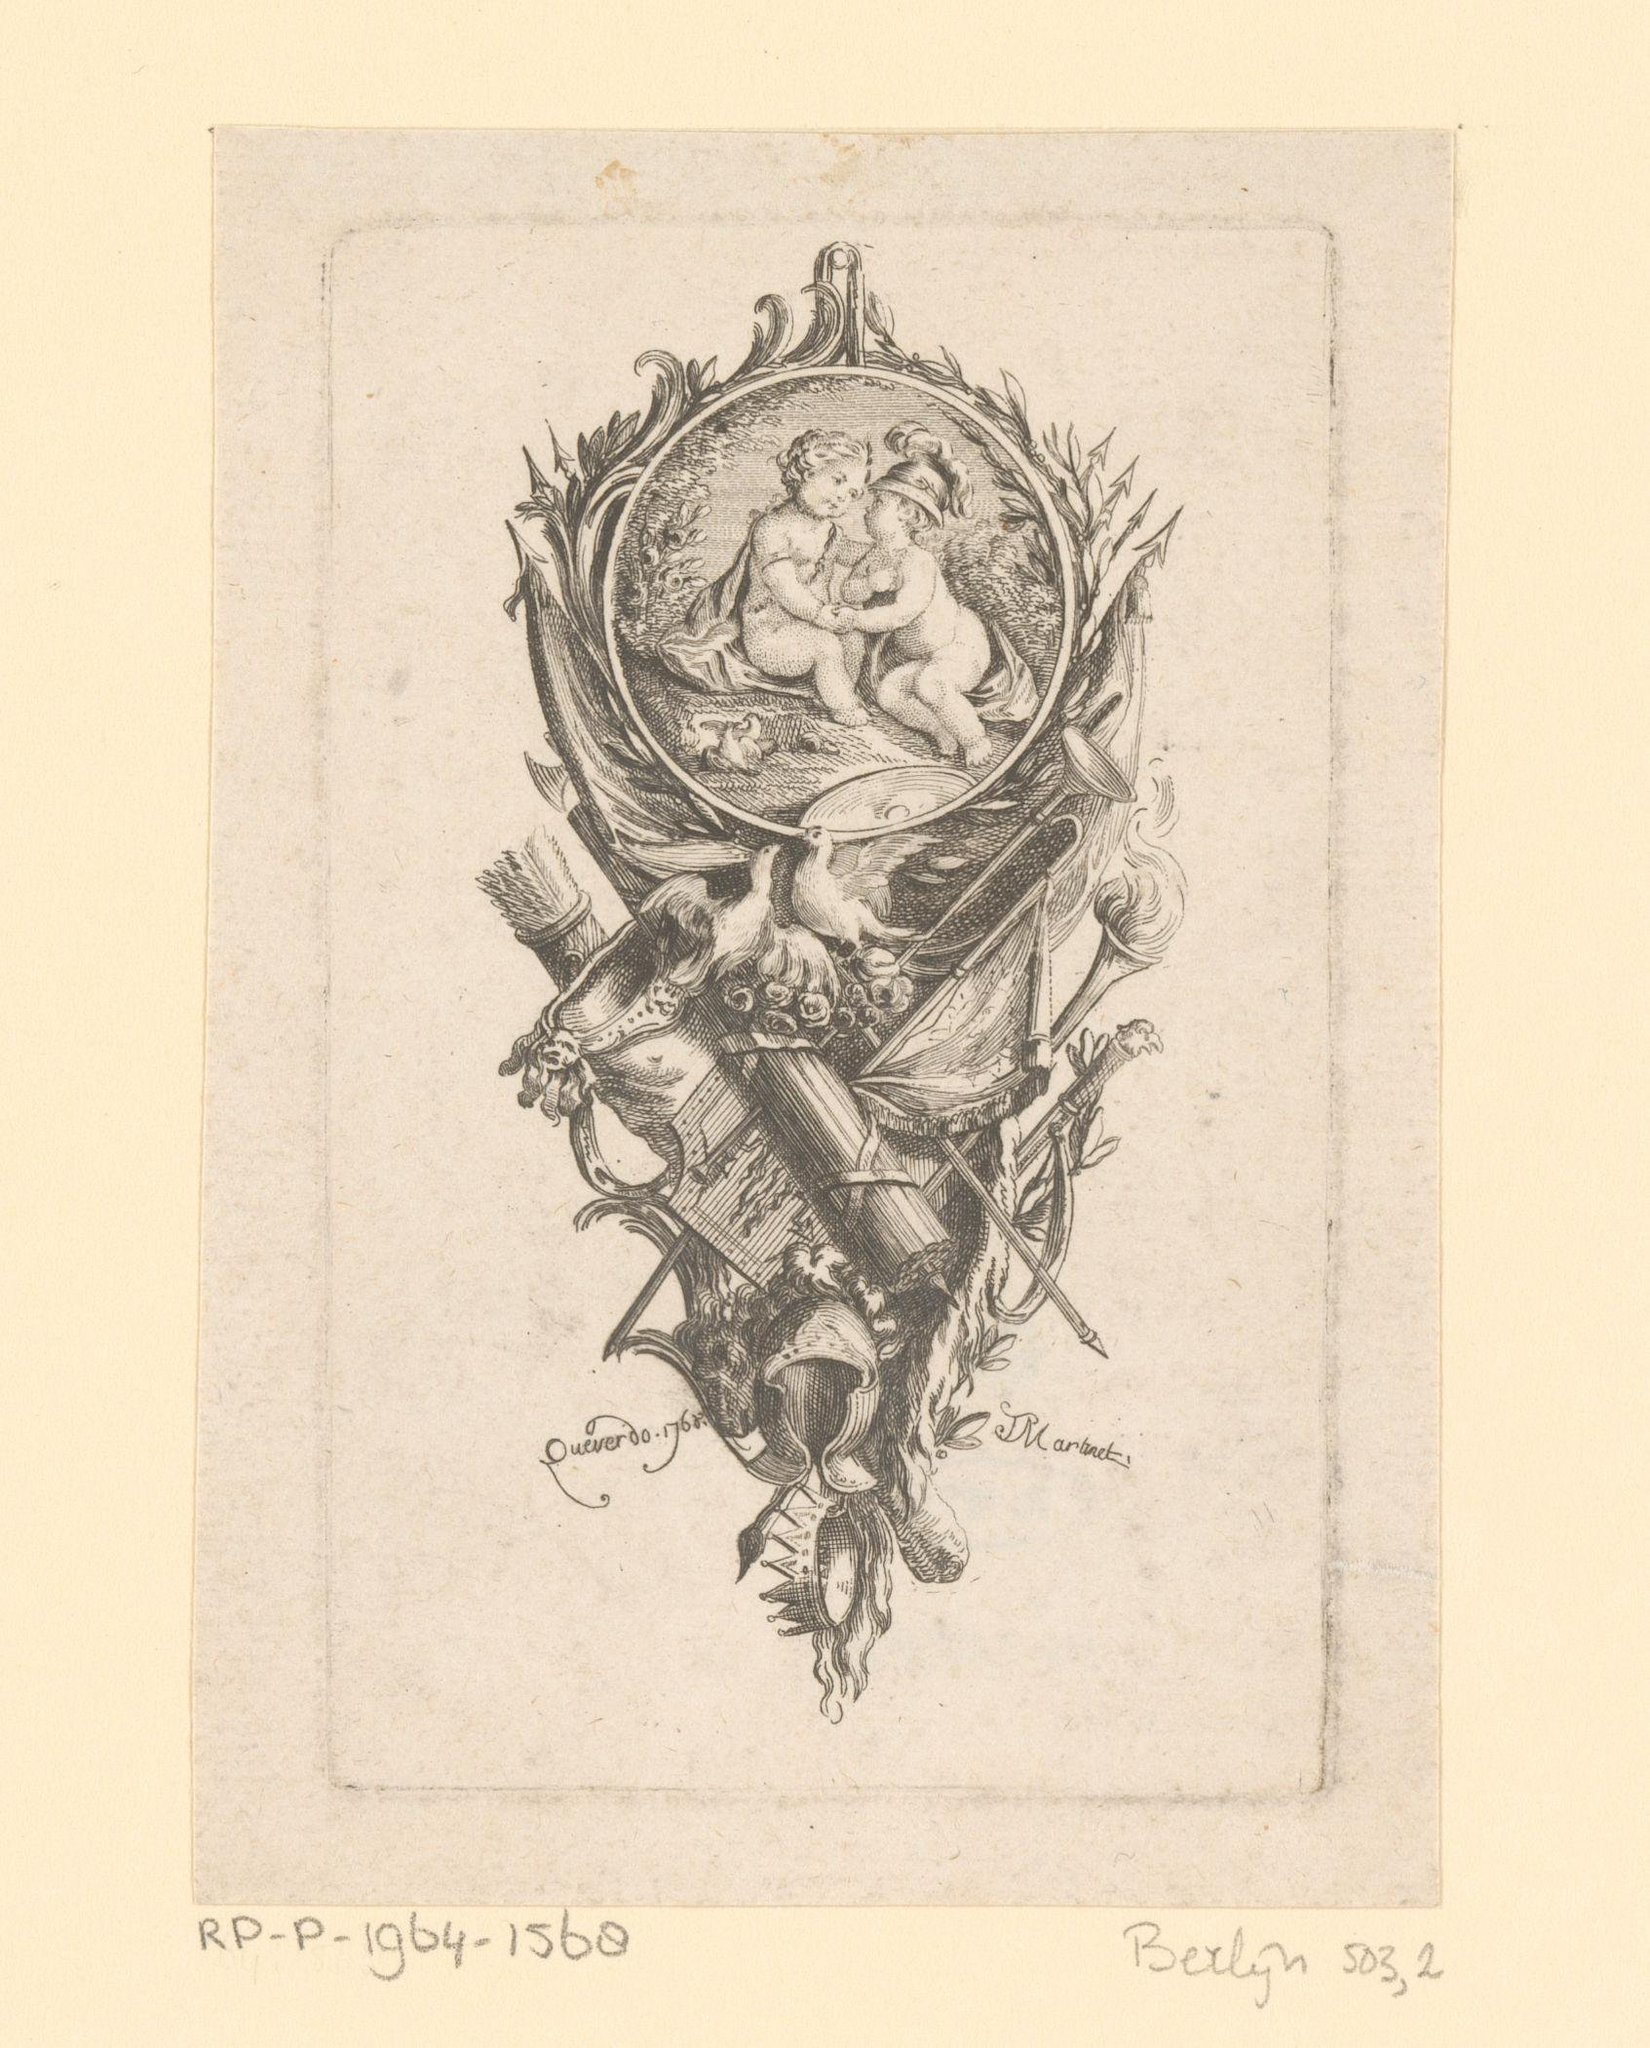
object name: print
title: Trofeeën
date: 1768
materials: paper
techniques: etching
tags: trophy, i.e.: decorative arrangement of symbolic or typical objects ~ ornament, weapons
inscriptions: collector's mark: Lugt 2760, collector's mark: Lugt 2228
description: Een trofee met wapens zoals een fasces, een pijlenkoker, een schild en speren en duiven, een helm, fakkel en kroon. Aan de bovenzijde een rond medaillon met twee putti.